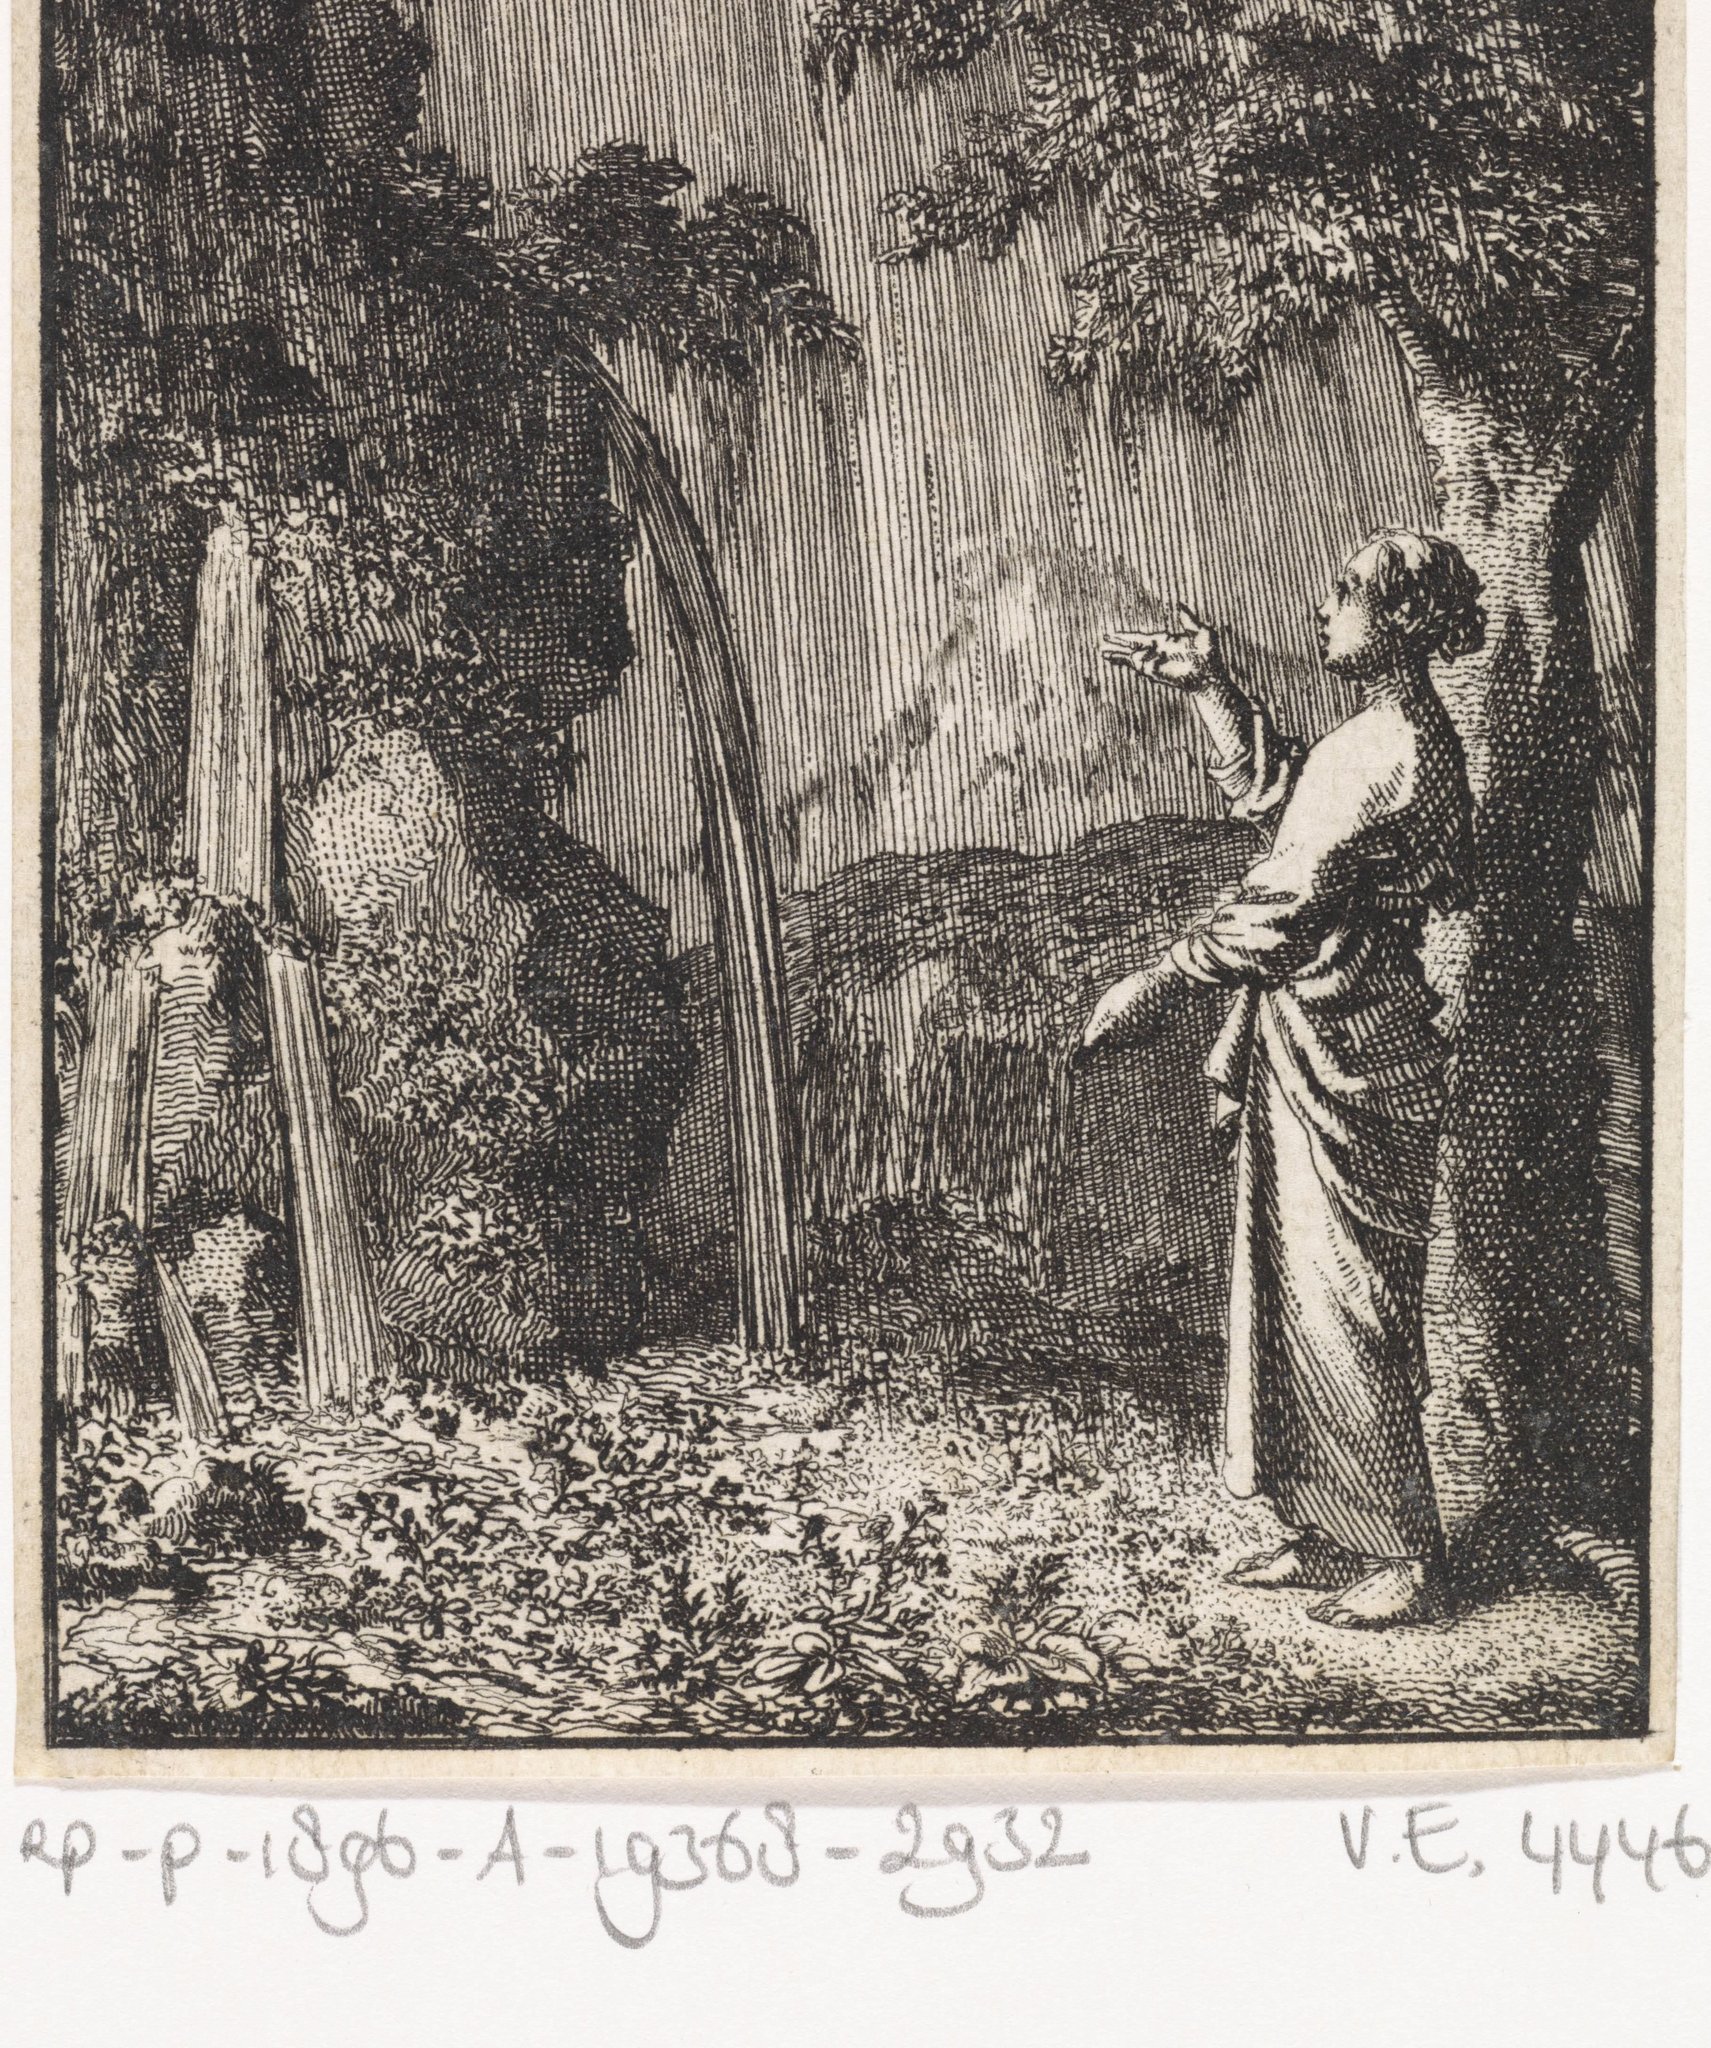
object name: print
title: De Ziel in beschouwing van den regen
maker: jan luyken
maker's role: draughtsman, print maker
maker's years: 1649-1712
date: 1714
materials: paper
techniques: etching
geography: amsterdam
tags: rain, the soul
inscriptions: collector's mark: Lugt 2228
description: Proefdruk van illustratie uit: Luyken, Jan. Jezus en de Ziel, 3 delen. Amsterdam: Wed. Pieter Arentsz II en Cornelis van der Sys, 1714, dl. I, p. 31.